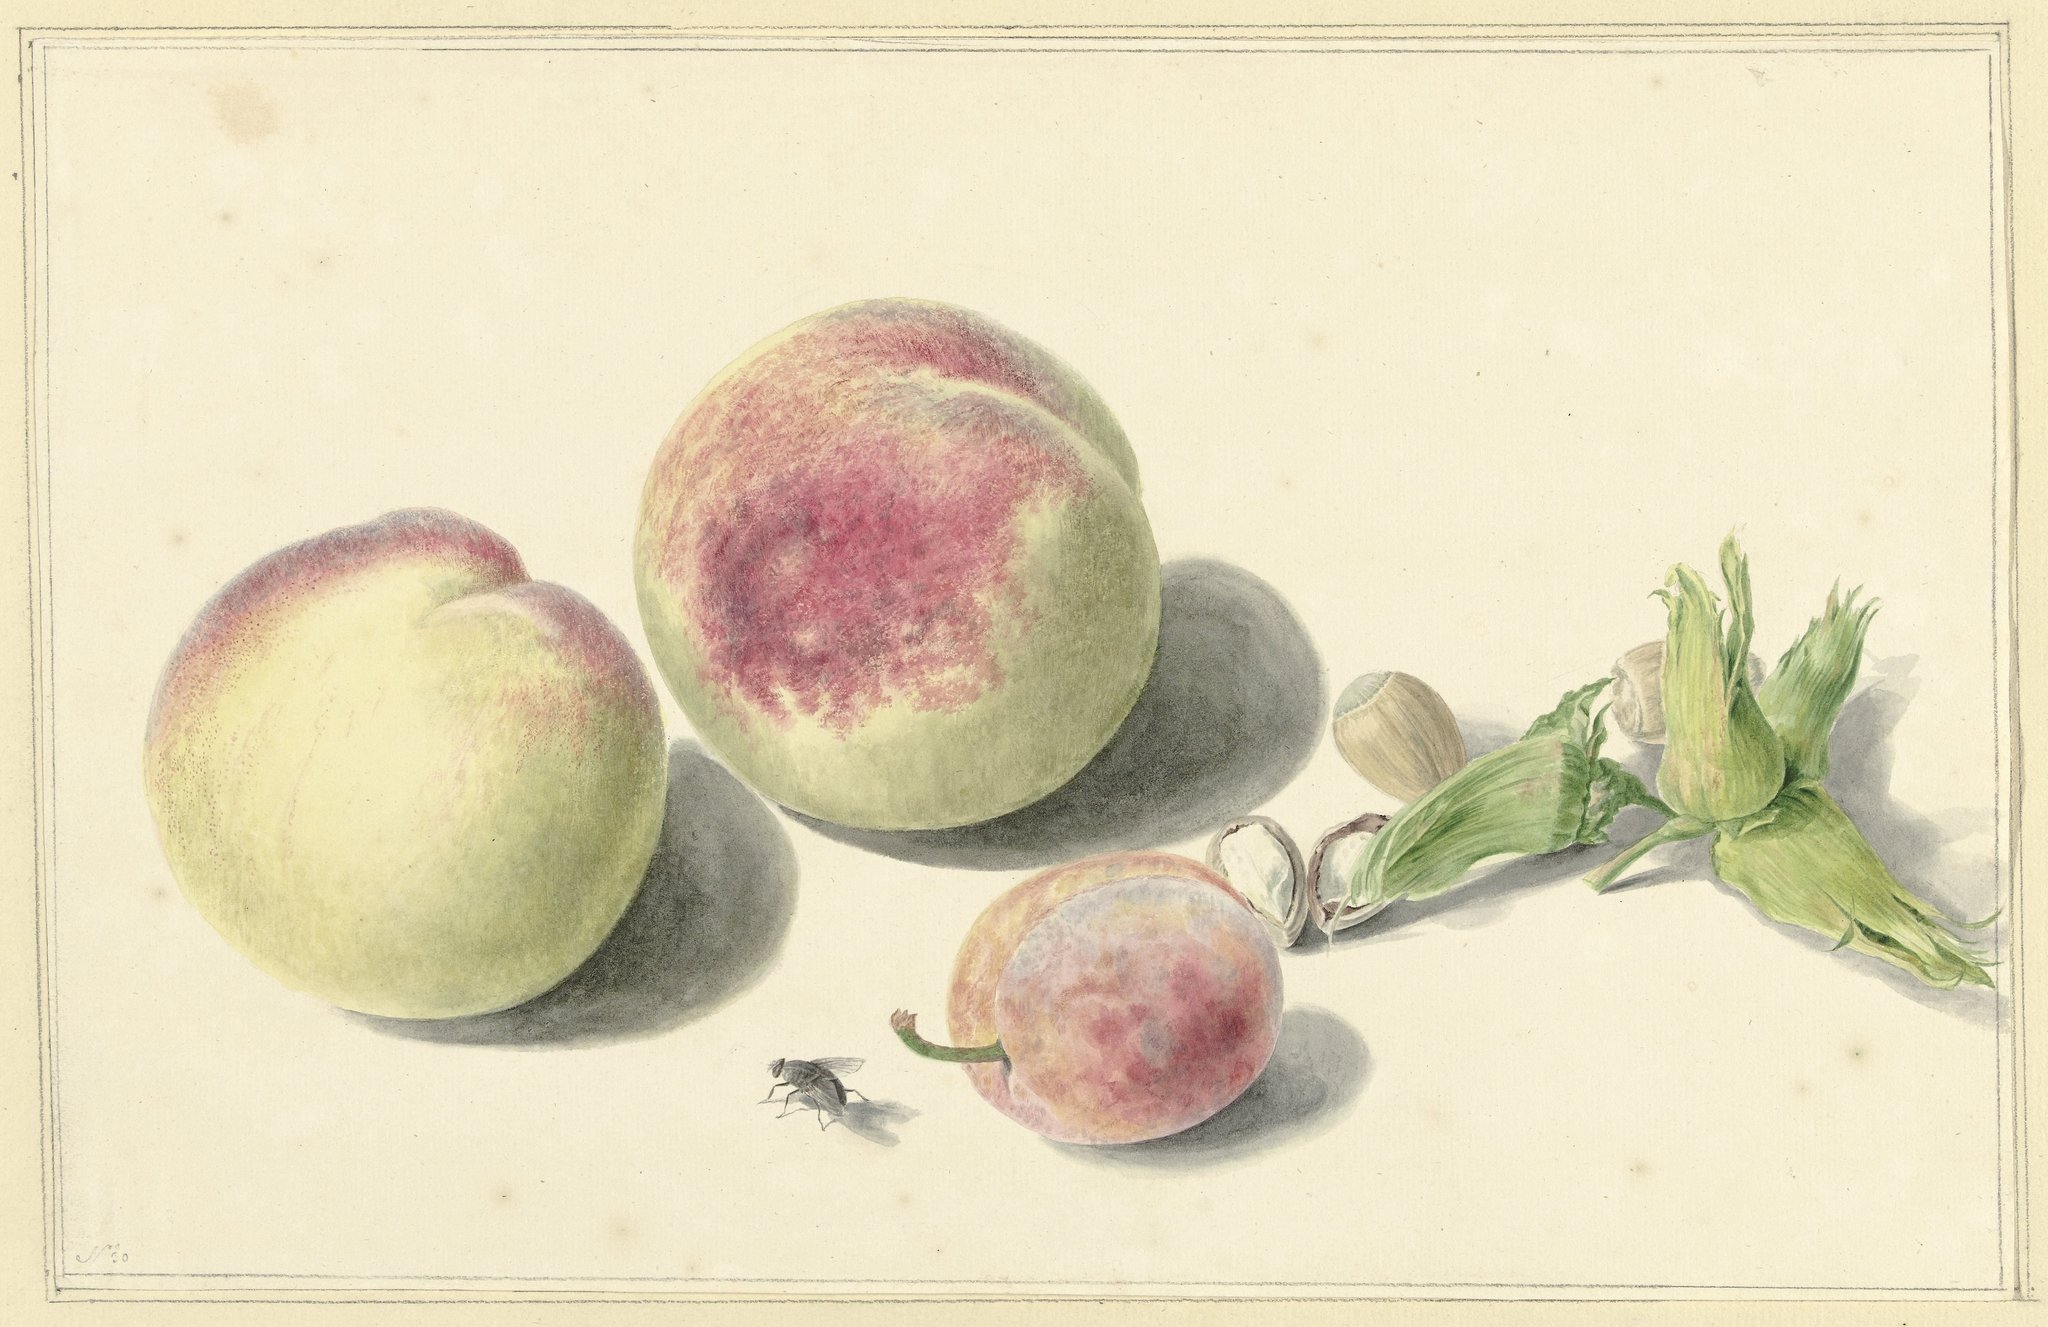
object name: watercolor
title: Perziken, noten, een pruim en een vlieg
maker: elisabeth geertruida van de kasteele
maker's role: draughtsman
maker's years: 1808-1853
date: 1818-1853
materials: paper, pencil, watercolor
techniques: brush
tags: fruits: plum, fruits: nuts, fruit, fruits: peach